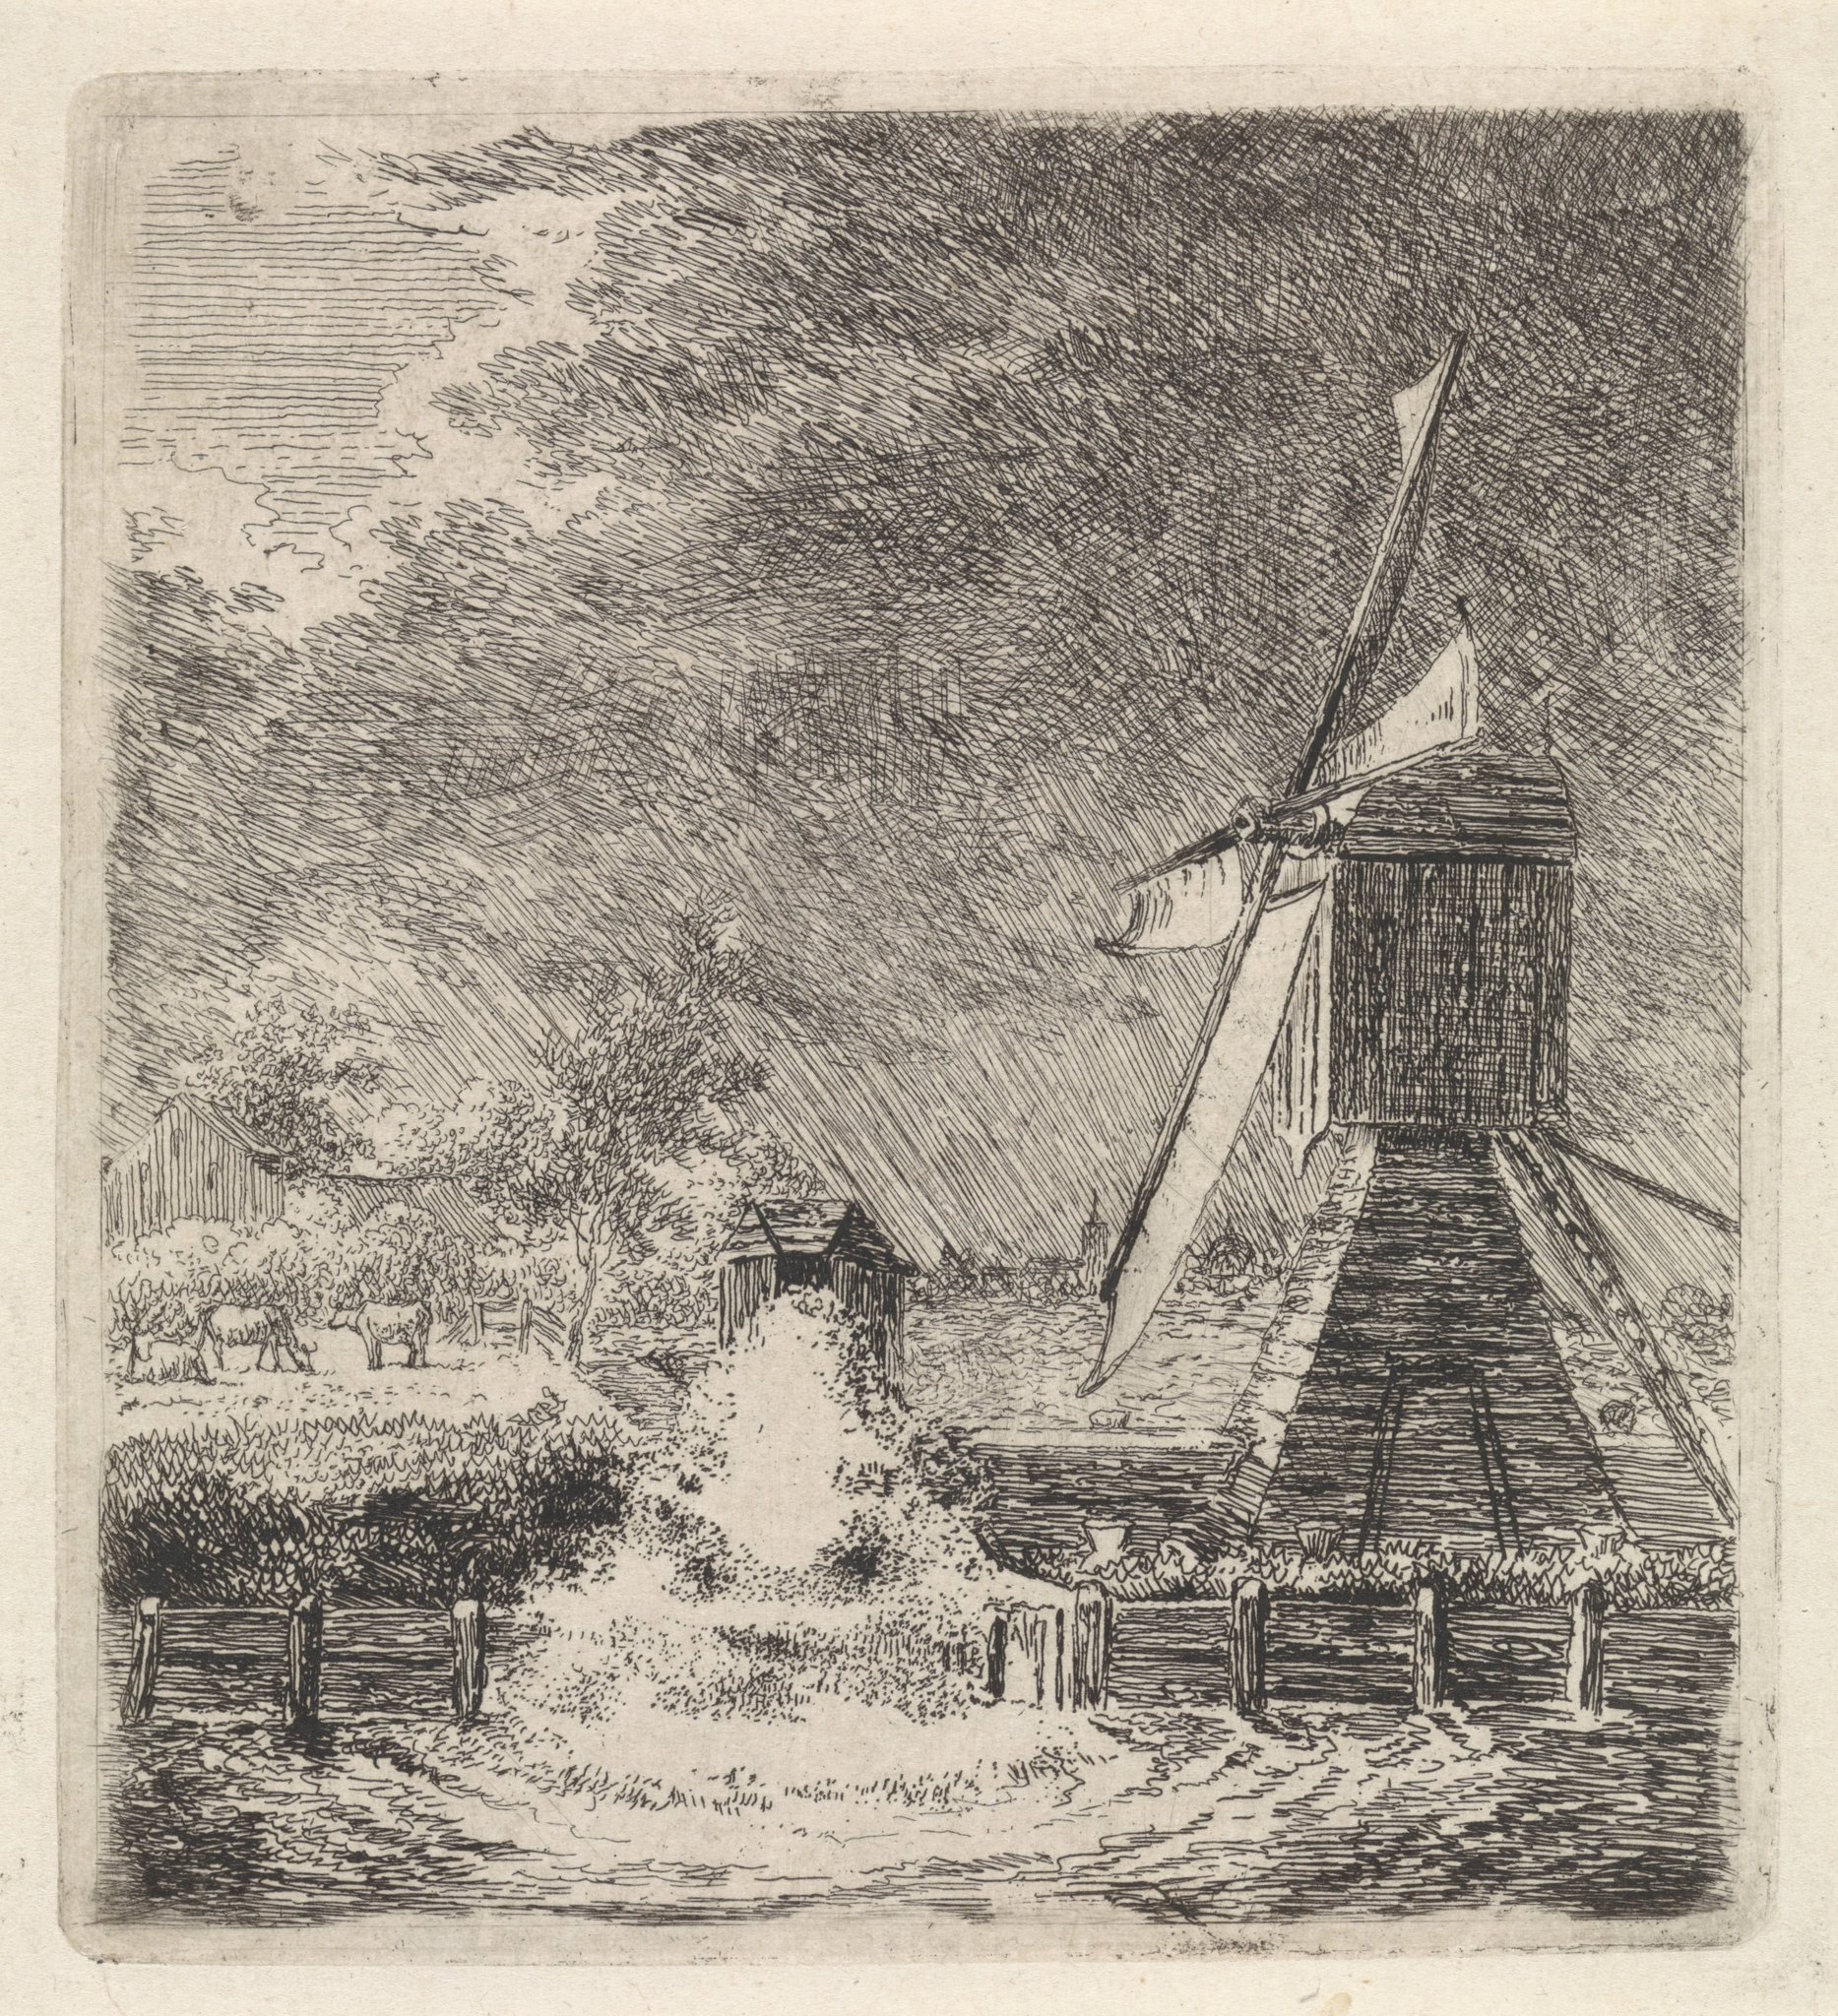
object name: print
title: Landschap met watermolen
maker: johannes christiaan janson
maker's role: draughtsman, painter, print maker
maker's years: 1763-1823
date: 1778-1823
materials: paper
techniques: etching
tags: watermill in landscape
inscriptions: collector's mark: Lugt 240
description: Landschap met watermolen, met water in rivier stromend. Links op de achtergrond een boerderij en koeien in de wei.